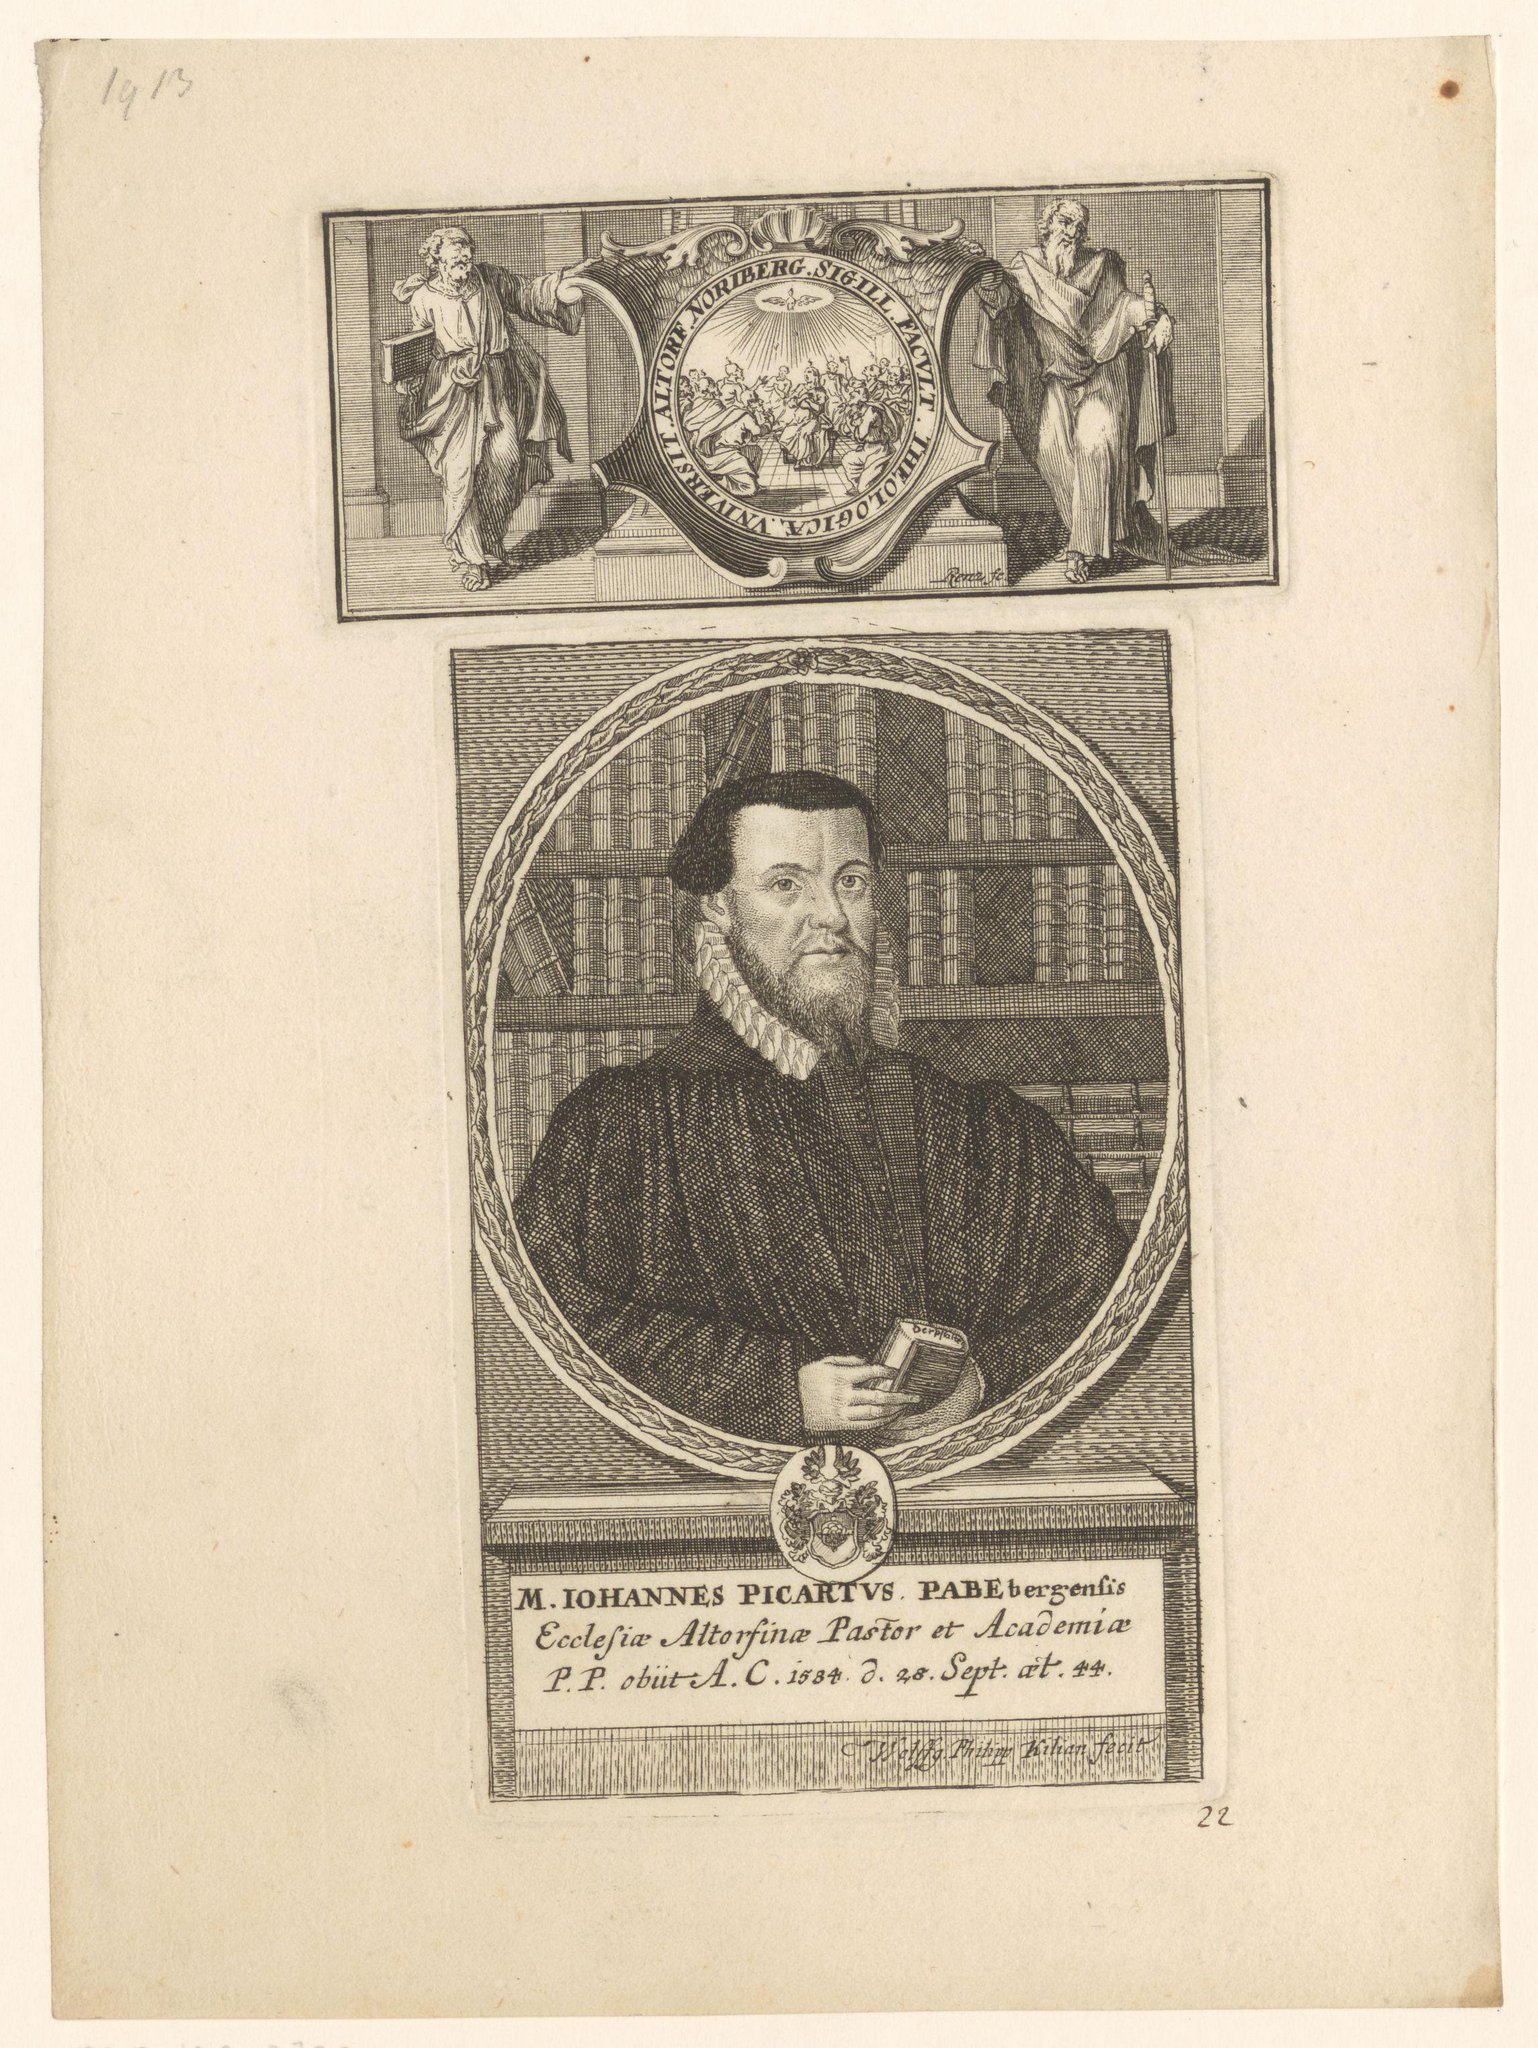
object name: print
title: Portret van Johann Picardt op 44-jarige leeftijd en een vignet met voorstelling van de uitstorting van de Heilige Geest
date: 1711-1722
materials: paper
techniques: engraving, etching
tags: johan picardt, theologian, historical persons, pentecost: the holy ghost descends upon (mary and) the apostles, sometimes paul and/or representatives of the nations present (acts 2:1-4)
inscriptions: number: ‘22’, collector's mark: Lugt 2228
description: Bovenaan een vignet voor de faculteit van theologie van de universiteit van Altdorf met een voorstelling van de uitstorting van de Heilige Geest. Tekst in het Latijn in de ondermarge van het portret.